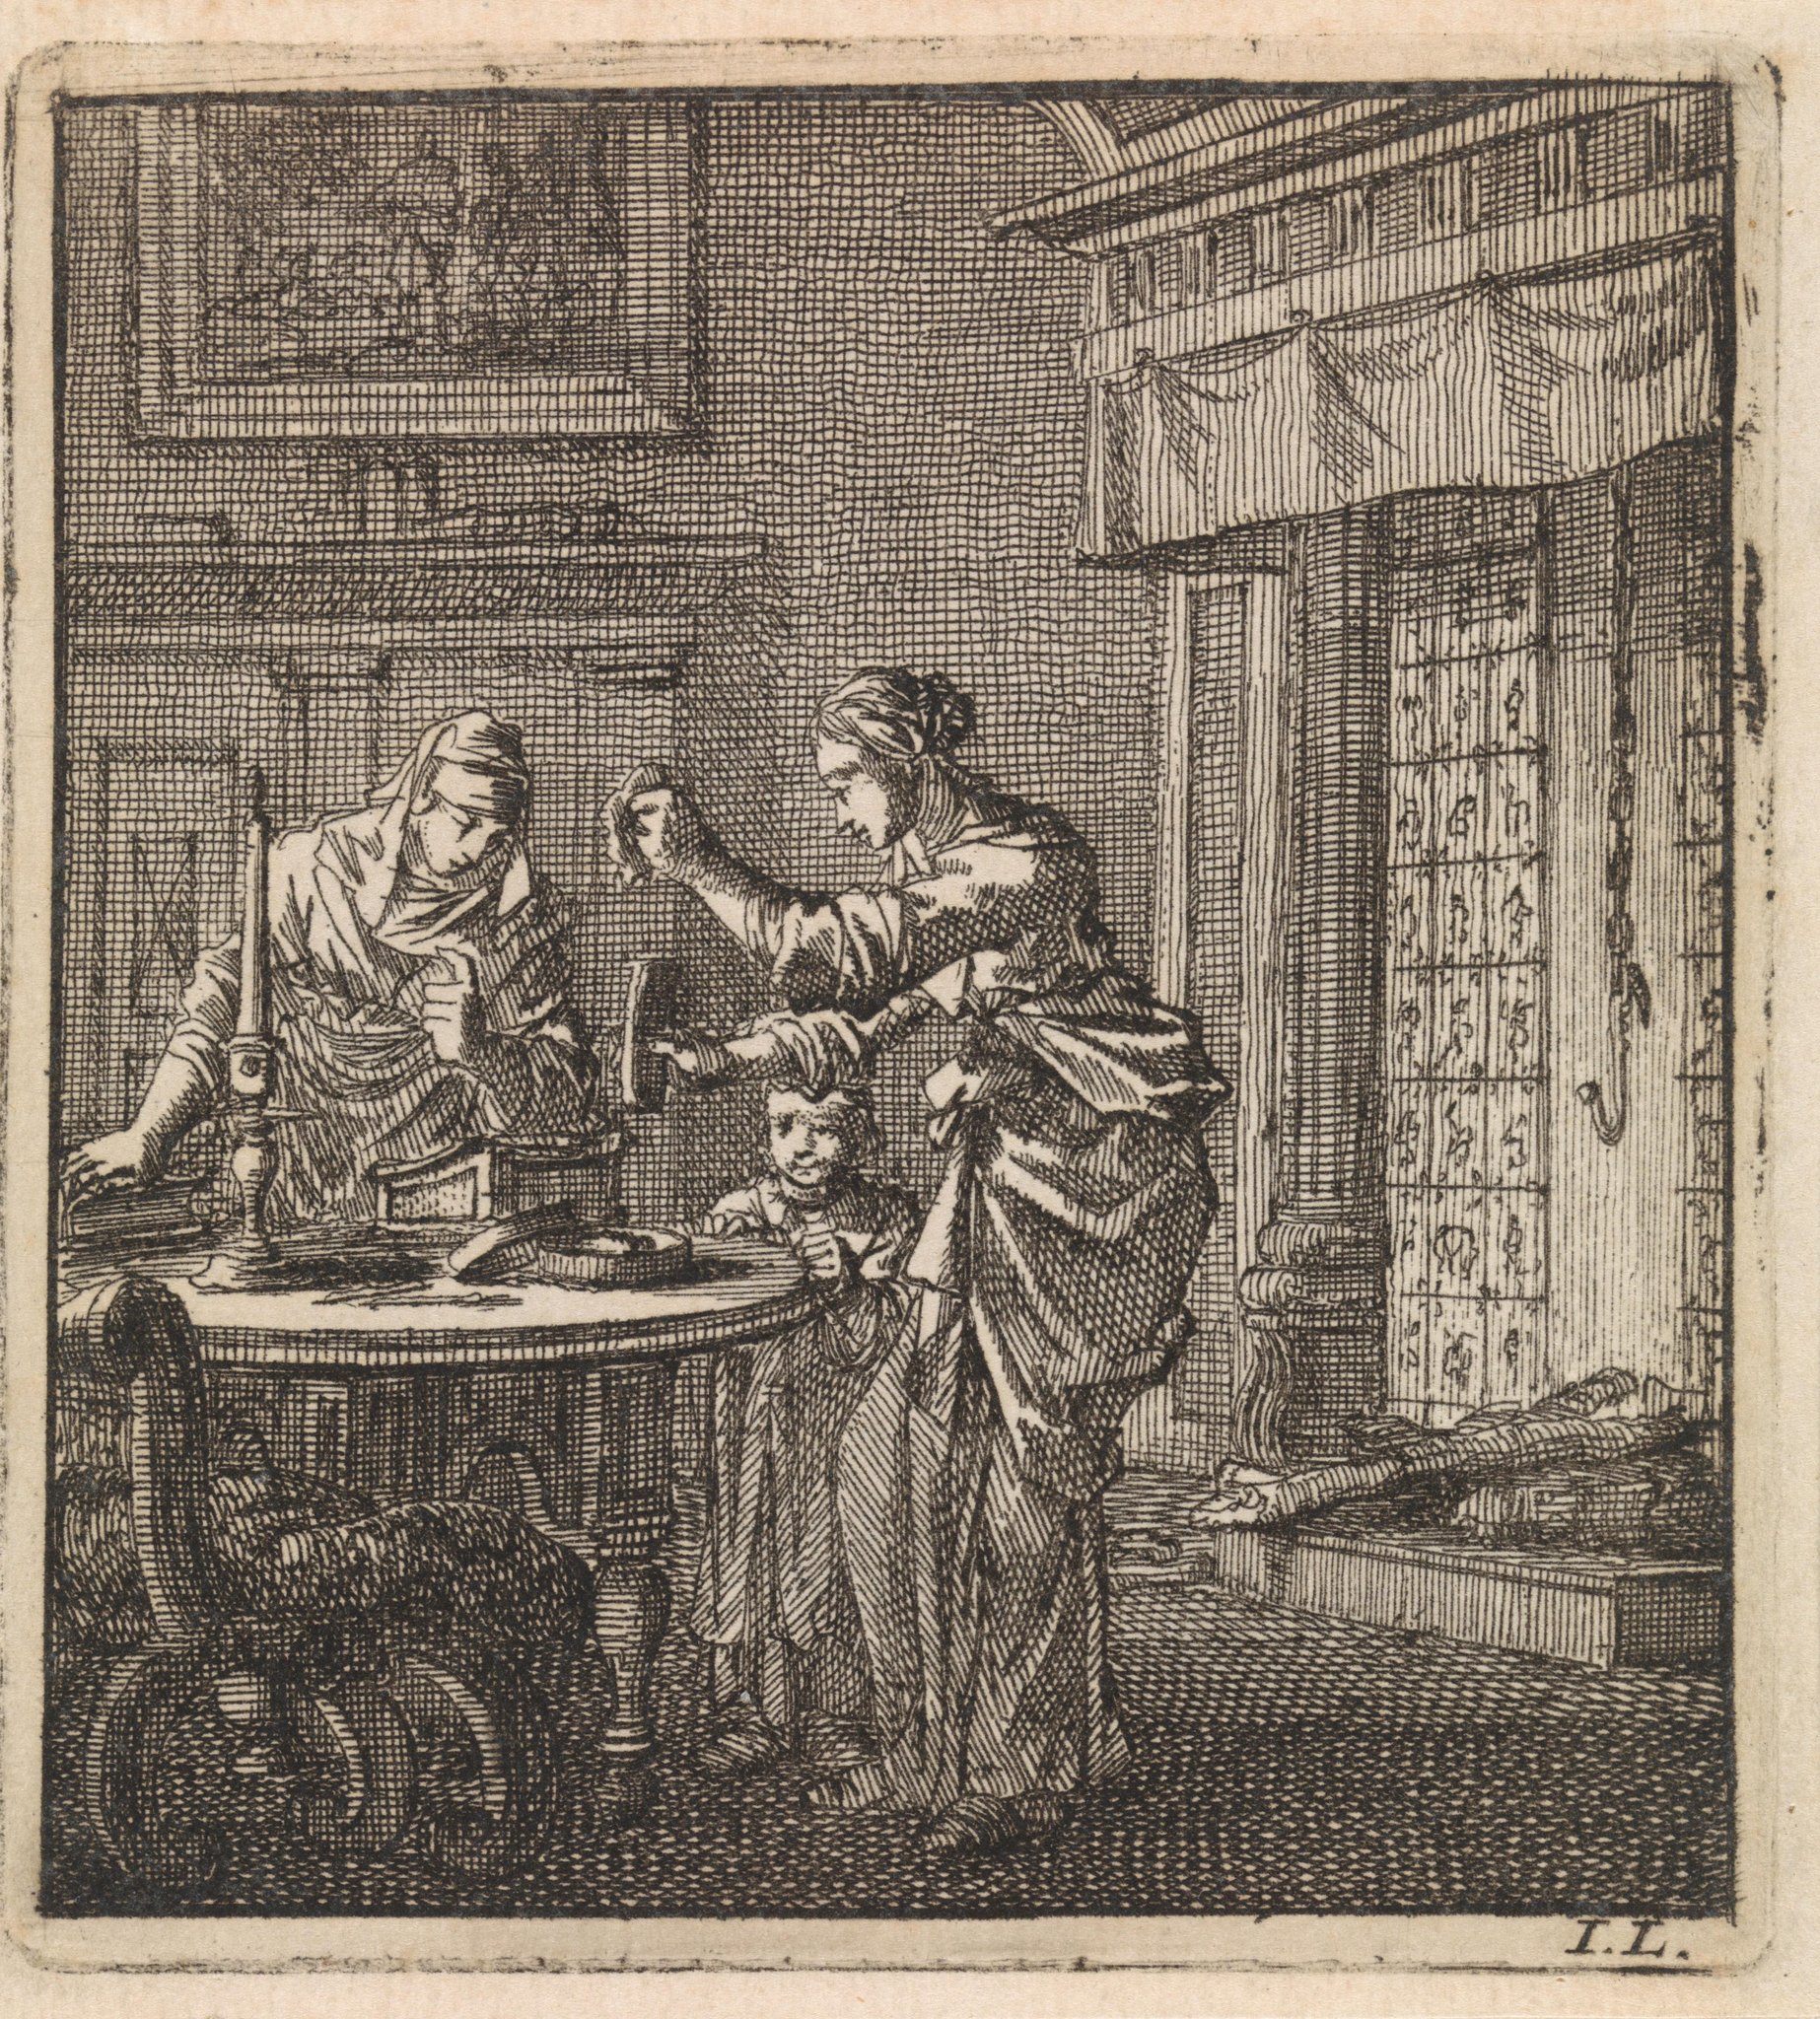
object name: print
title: Vrouw probeert vonken te slaan met een vuursteen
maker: jan luyken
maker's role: draughtsman, print maker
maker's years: 1649-1712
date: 1711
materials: paper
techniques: etching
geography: amsterdam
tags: chimney, kinds of non-precious stone: flint, picture, painting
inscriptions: collector's mark: Lugt 2228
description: Illustratie voor: Luyken, Jan. Het leerzaam huisraad, vertoond in vyftig konstige figuuren, met godlyke spreuken en stichtelyke verzen: Pieter Arentsz. II (wed.) en Cornelis van der Sys, 1711, p. 42.